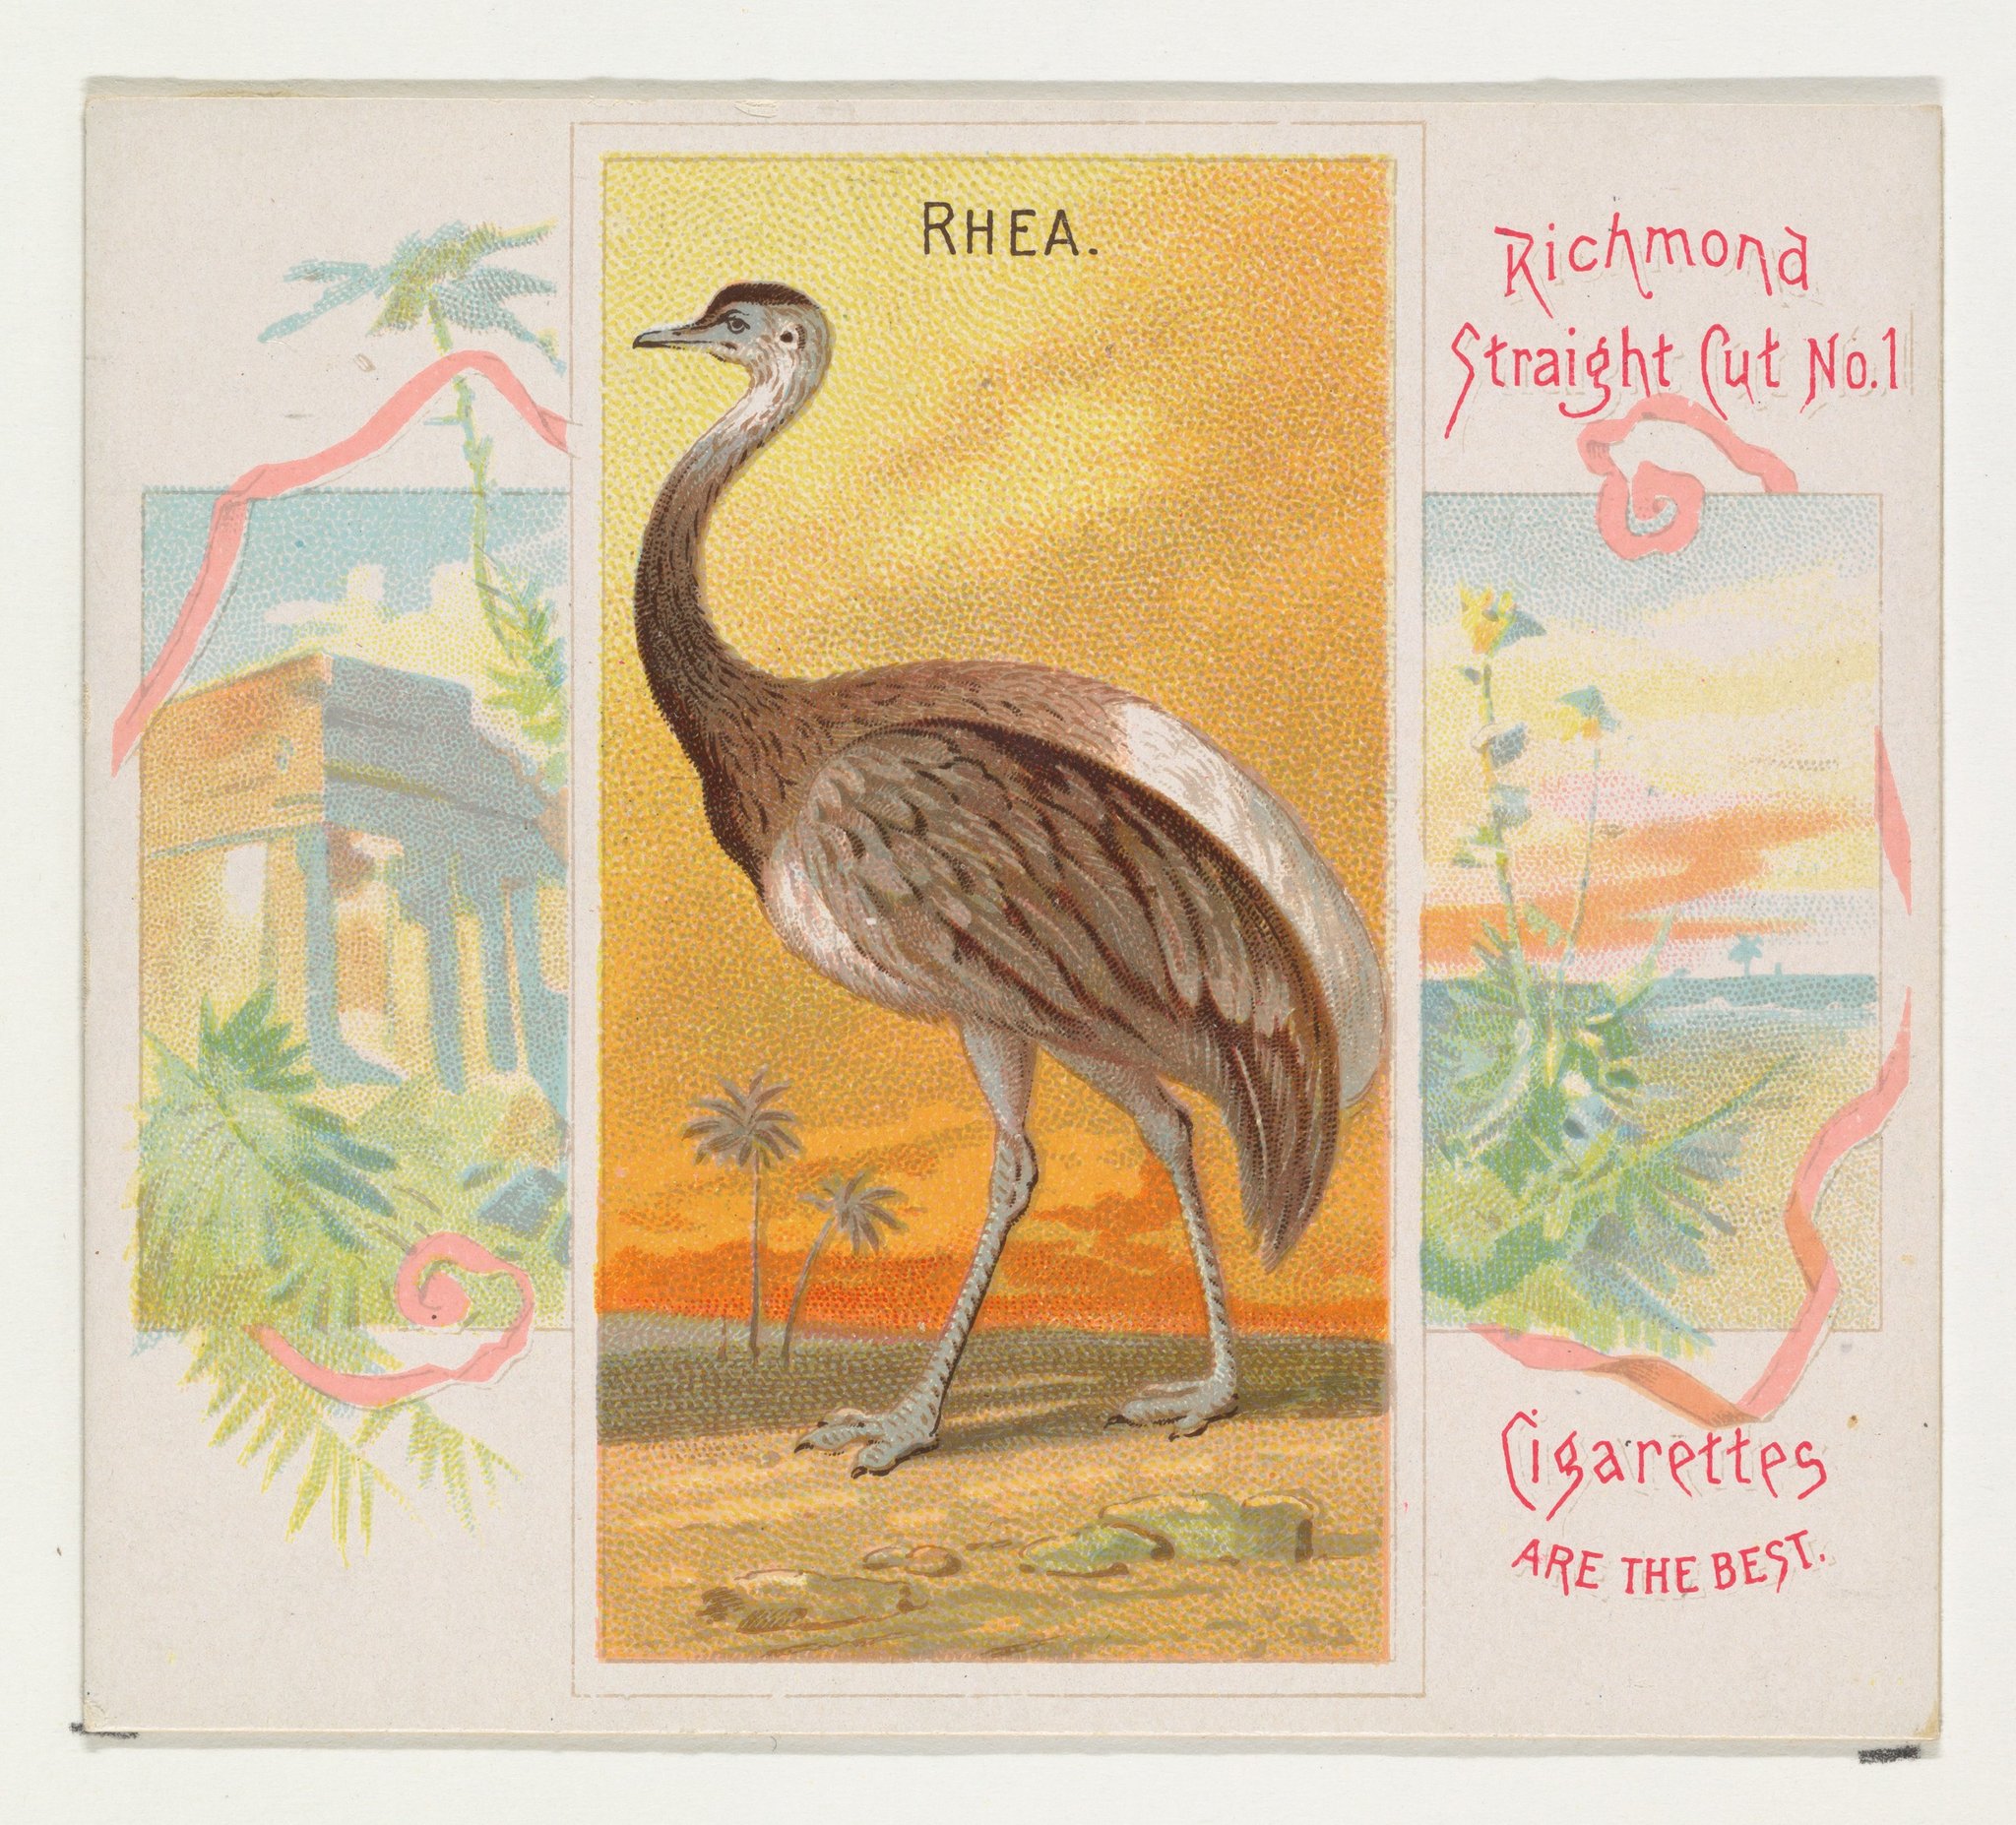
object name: print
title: Rhea, from Birds of the Tropics series (N38) for Allen & Ginter Cigarettes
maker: allen & ginter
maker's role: publisher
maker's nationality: american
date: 1889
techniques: color lithograph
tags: birds